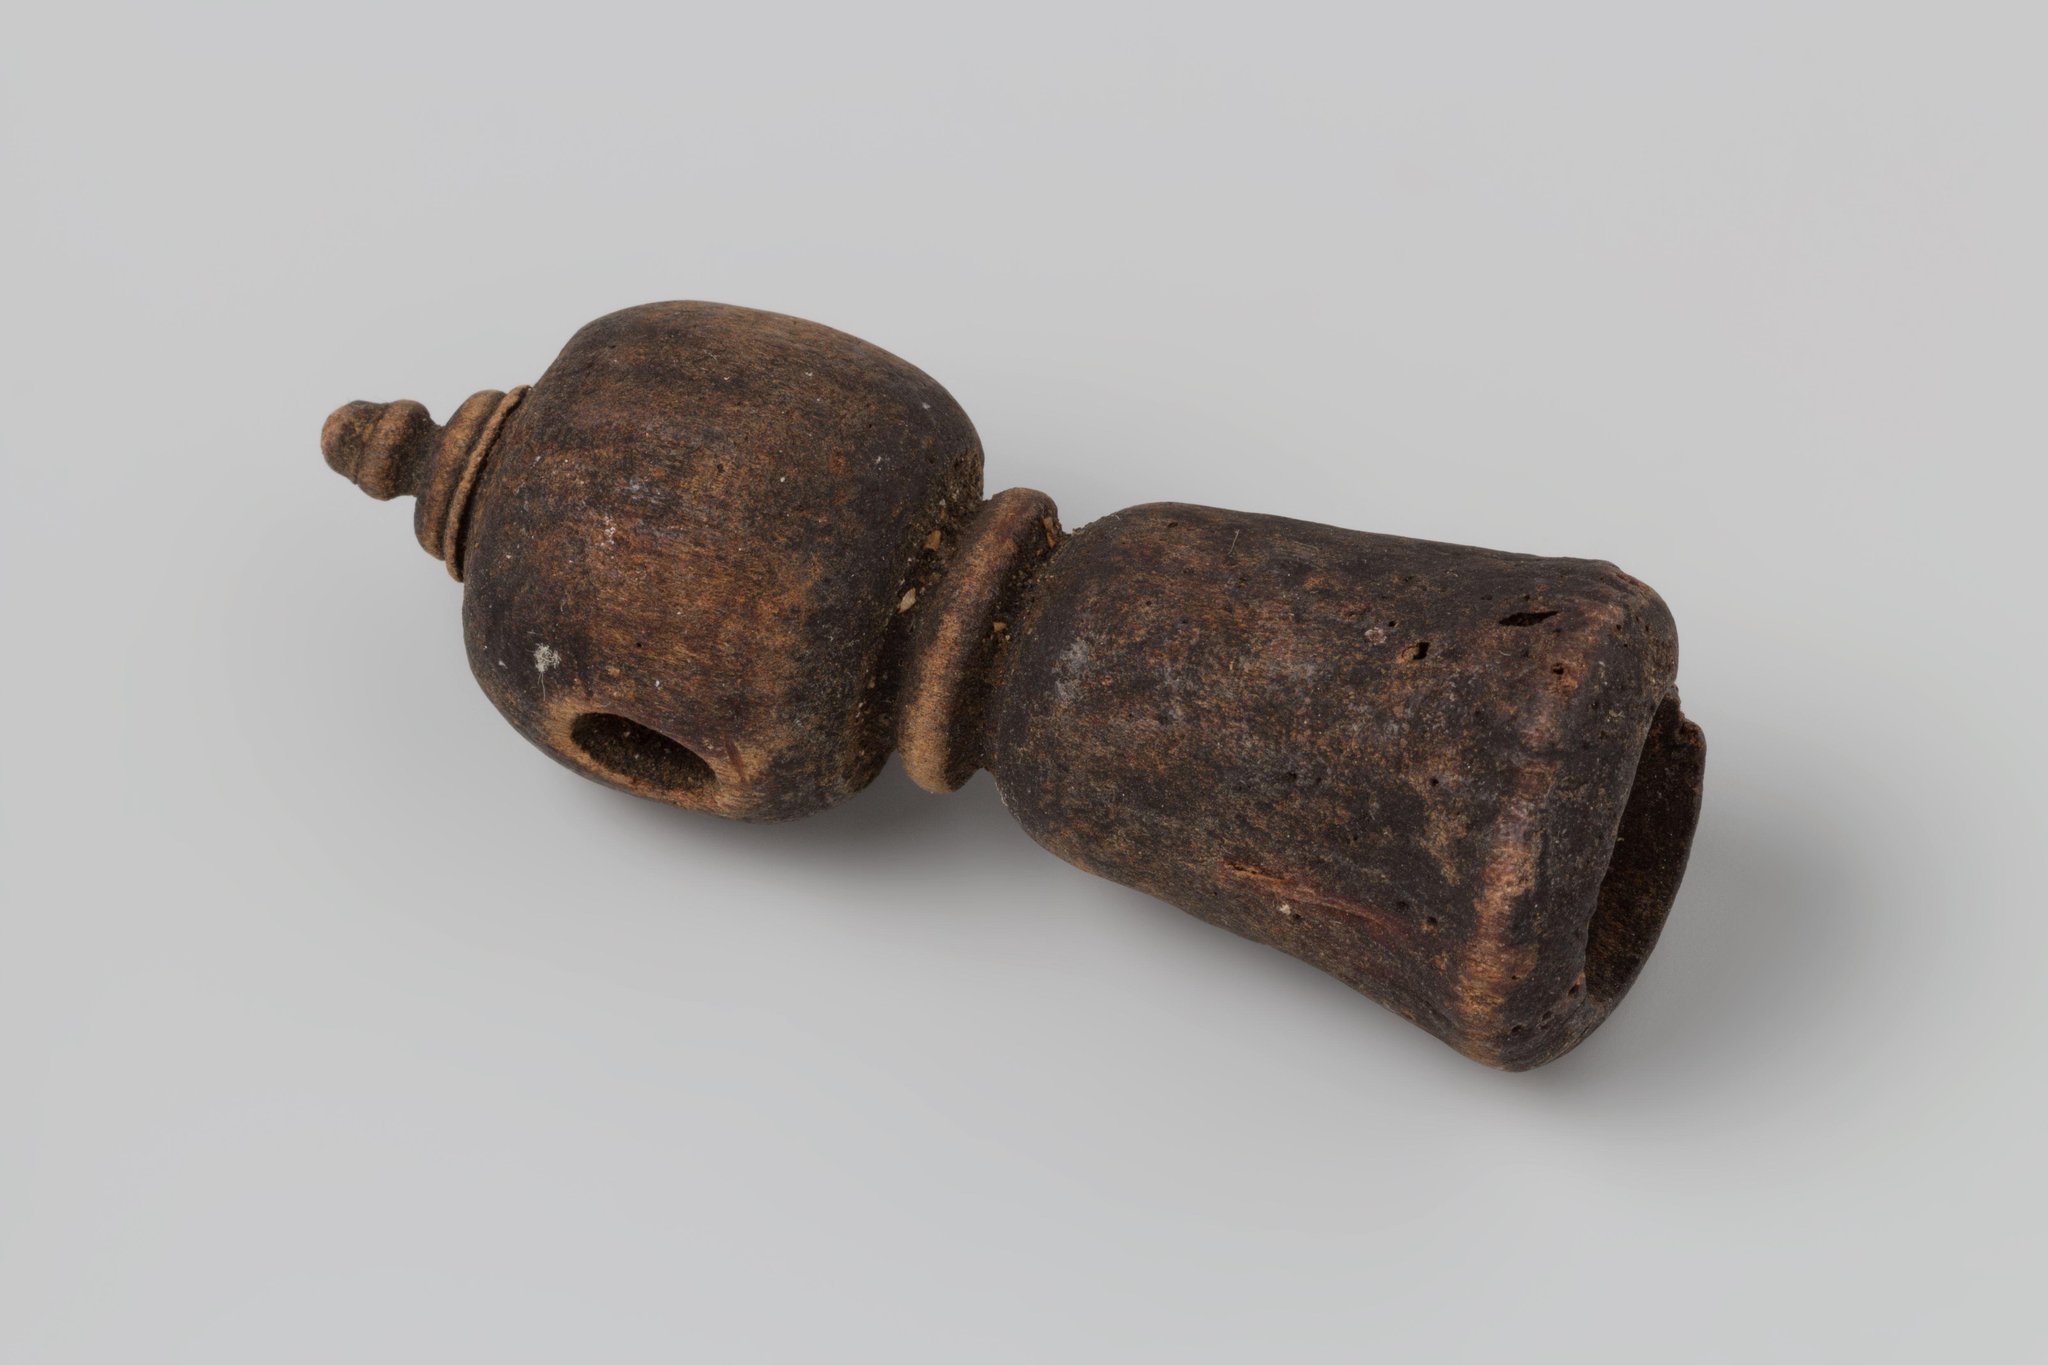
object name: object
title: Houten voorwerp uit V.O.C.-schip de 'Witte Leeuw'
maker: Anonymous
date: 1613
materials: wood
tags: verenigde oostindische compagnie, sint-helena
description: Houten voorwerp. Mogelijk knop van gordijnroede. Bestaande uit een taps toelopend deel en een bol met daarop een knop en een bolletje, verbonden door een ring, alles uit één stuk hout gedraaid. Aan de onderzijde een gat en in de bol een gat. Het hout is aan de onderzijde iets verweerd.